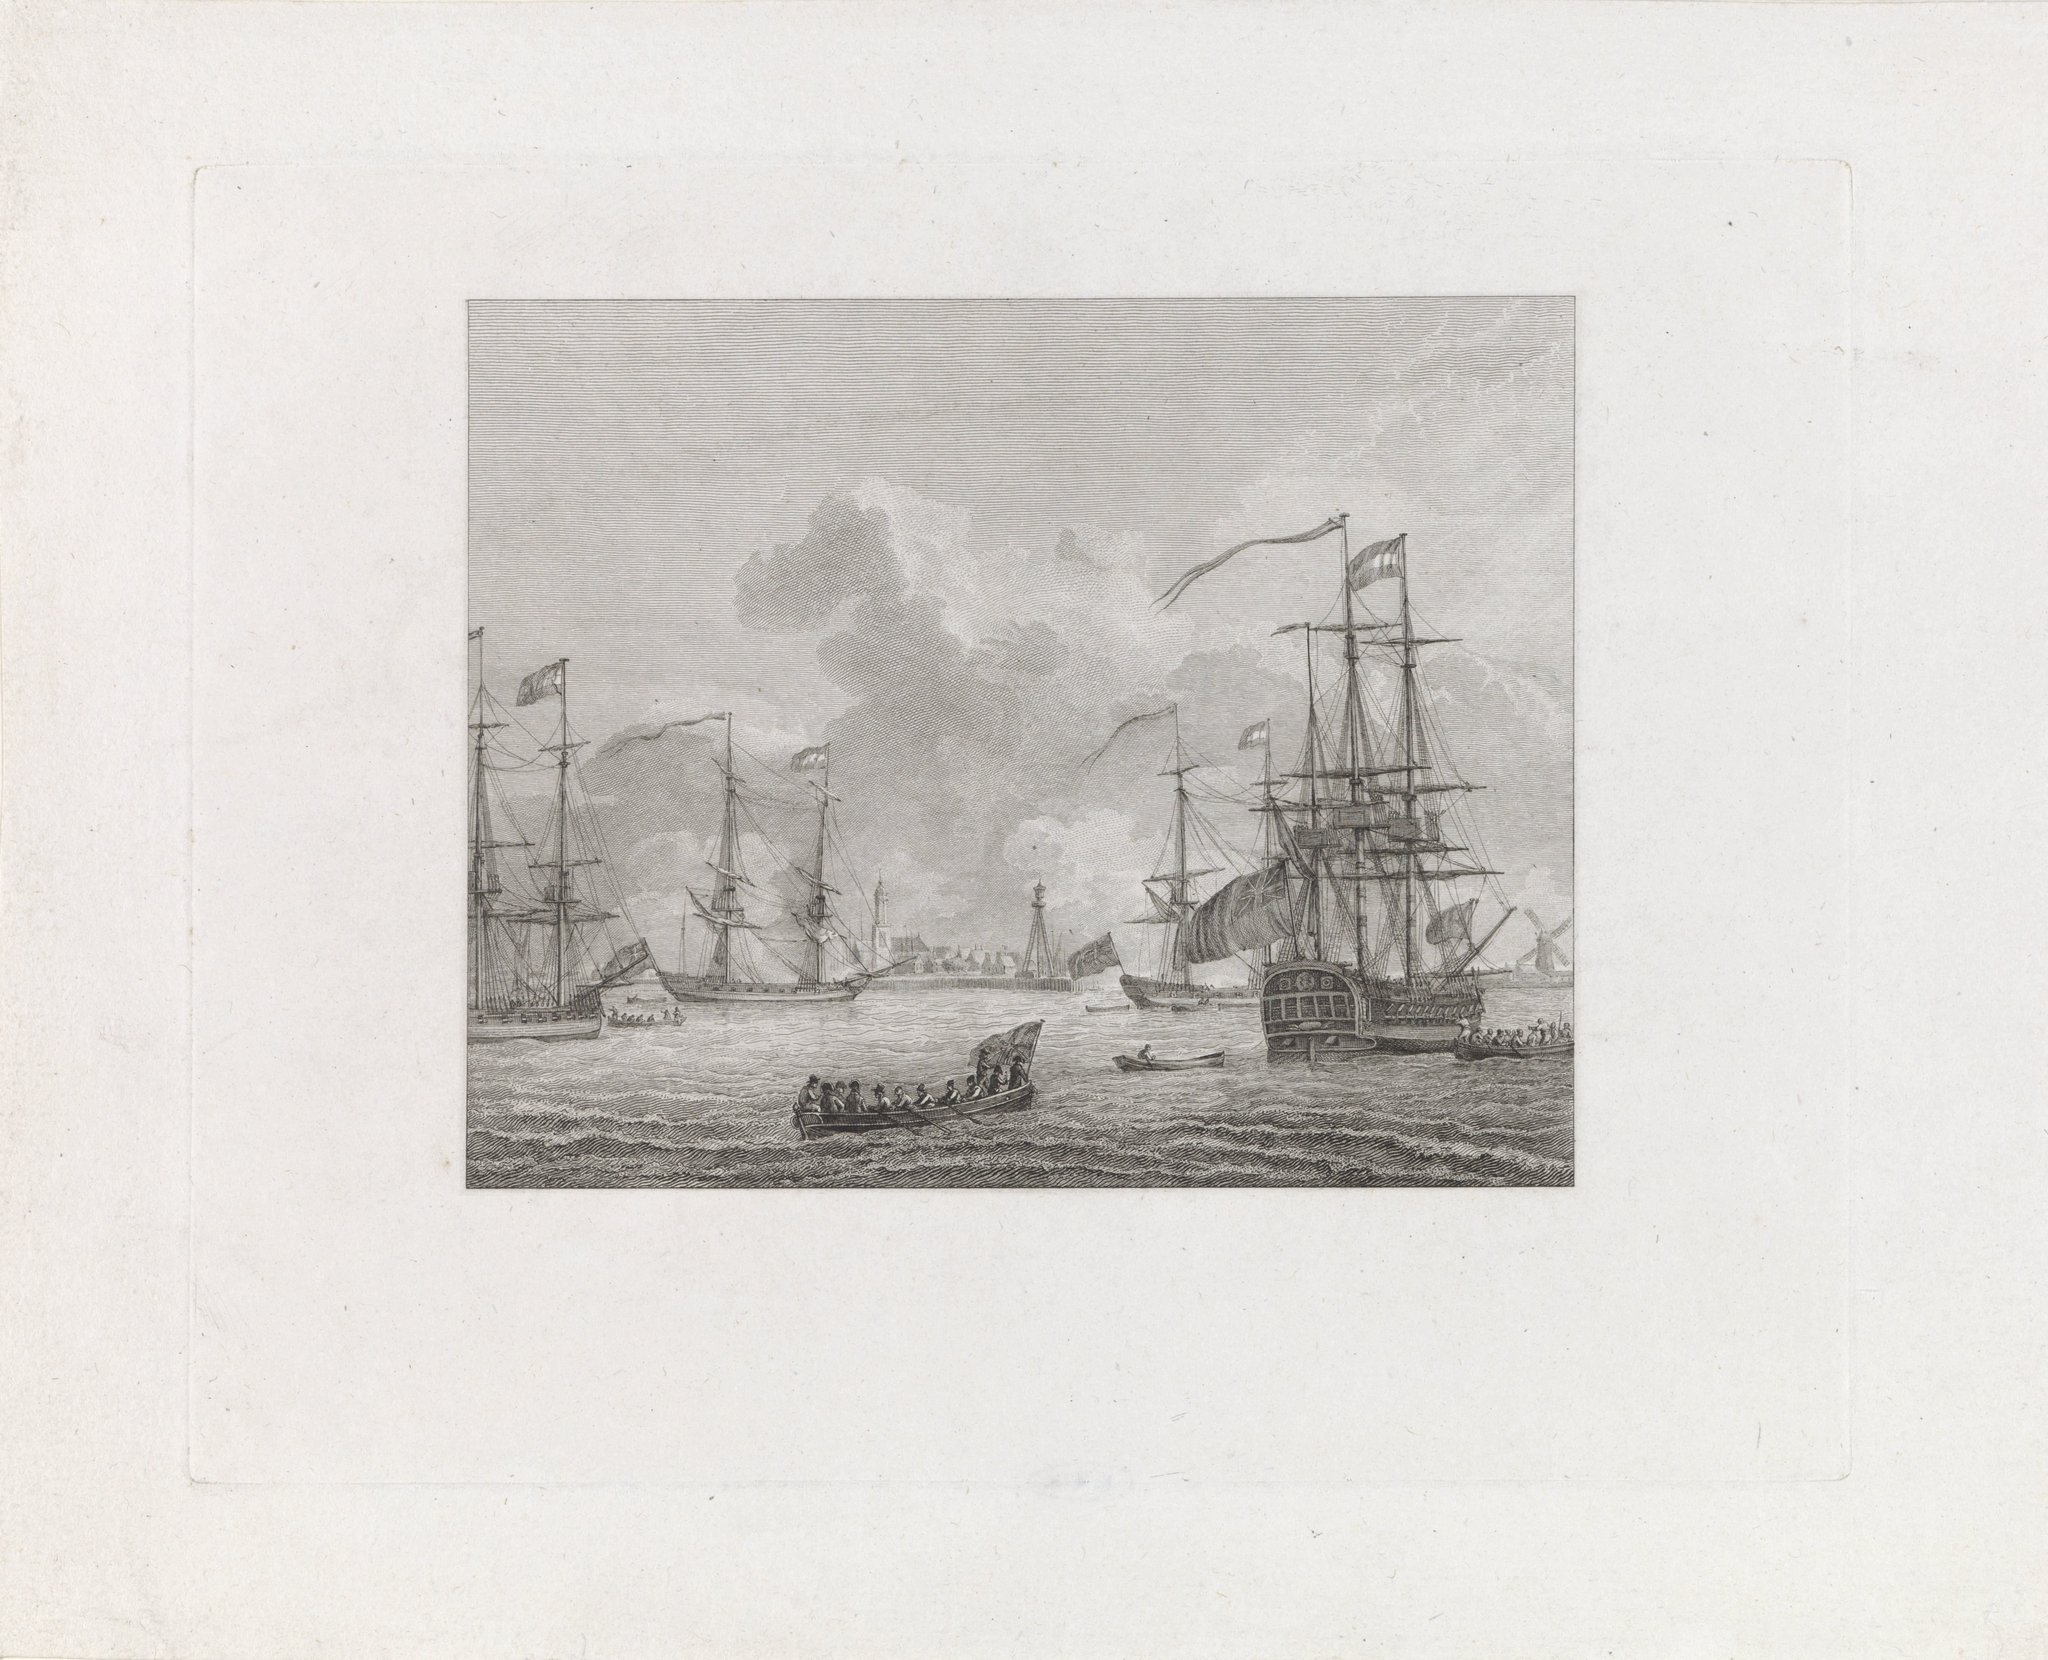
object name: print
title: Aanval van de Britten op Lemmer, 1799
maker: reinier vinkeles (i)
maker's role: draughtsman, print maker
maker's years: 1741-1816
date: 1800-1802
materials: paper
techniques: engraving, etching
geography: netherlands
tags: battle (+ sailing-ships)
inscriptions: collector's mark: Lugt 2228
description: Gebruikt als illustratie in: L.C. Vonk. Geschiedenis der landing van het Engelsch-Russisch leger in Noord-Holland; alsmede der krijgsbedrijven en politieke gebeurtenissen, zoo aldaar, als in Vriesland en Gelderland, in den jare 1799. Haarlem: François Bohn, 2 dln, 1801-1802.